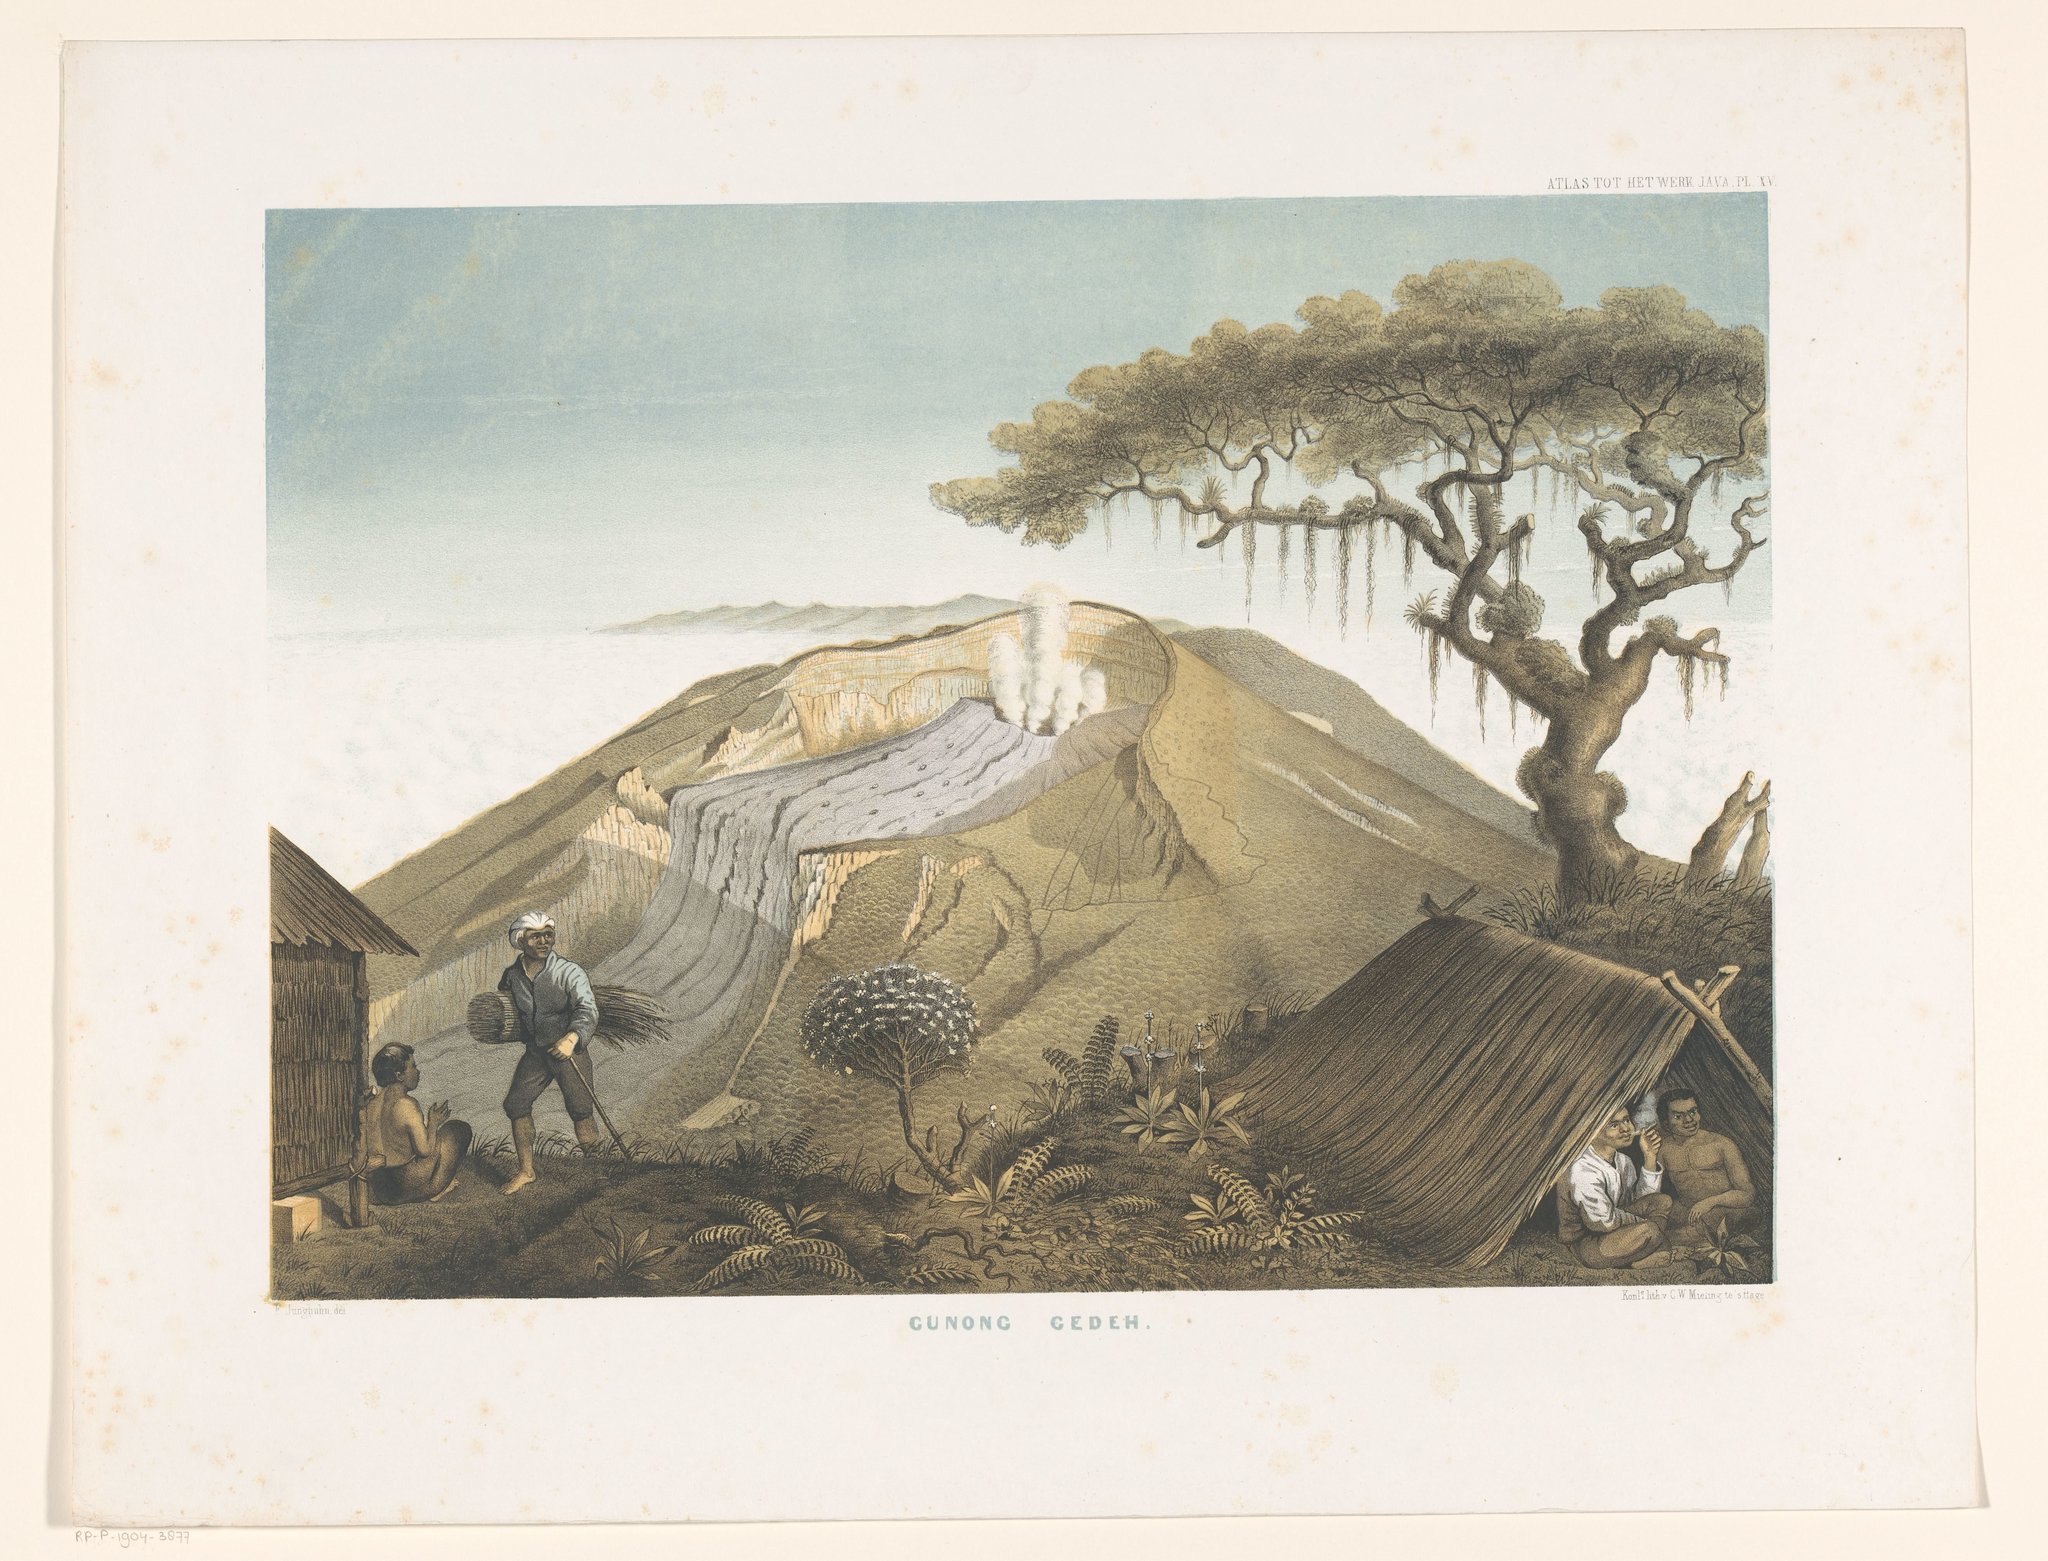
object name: print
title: Piëta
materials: paper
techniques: engraving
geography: antwerp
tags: the dead christ in mary's lap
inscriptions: collector's mark: Lugt 2542, collector's mark: Lugt 2228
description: Het lichaam van Christus ligt op de schoot van Maria, die haar zoon beweent. In de marge een Bijbelcitaat uit Hoogl. 1 in het Latijn.